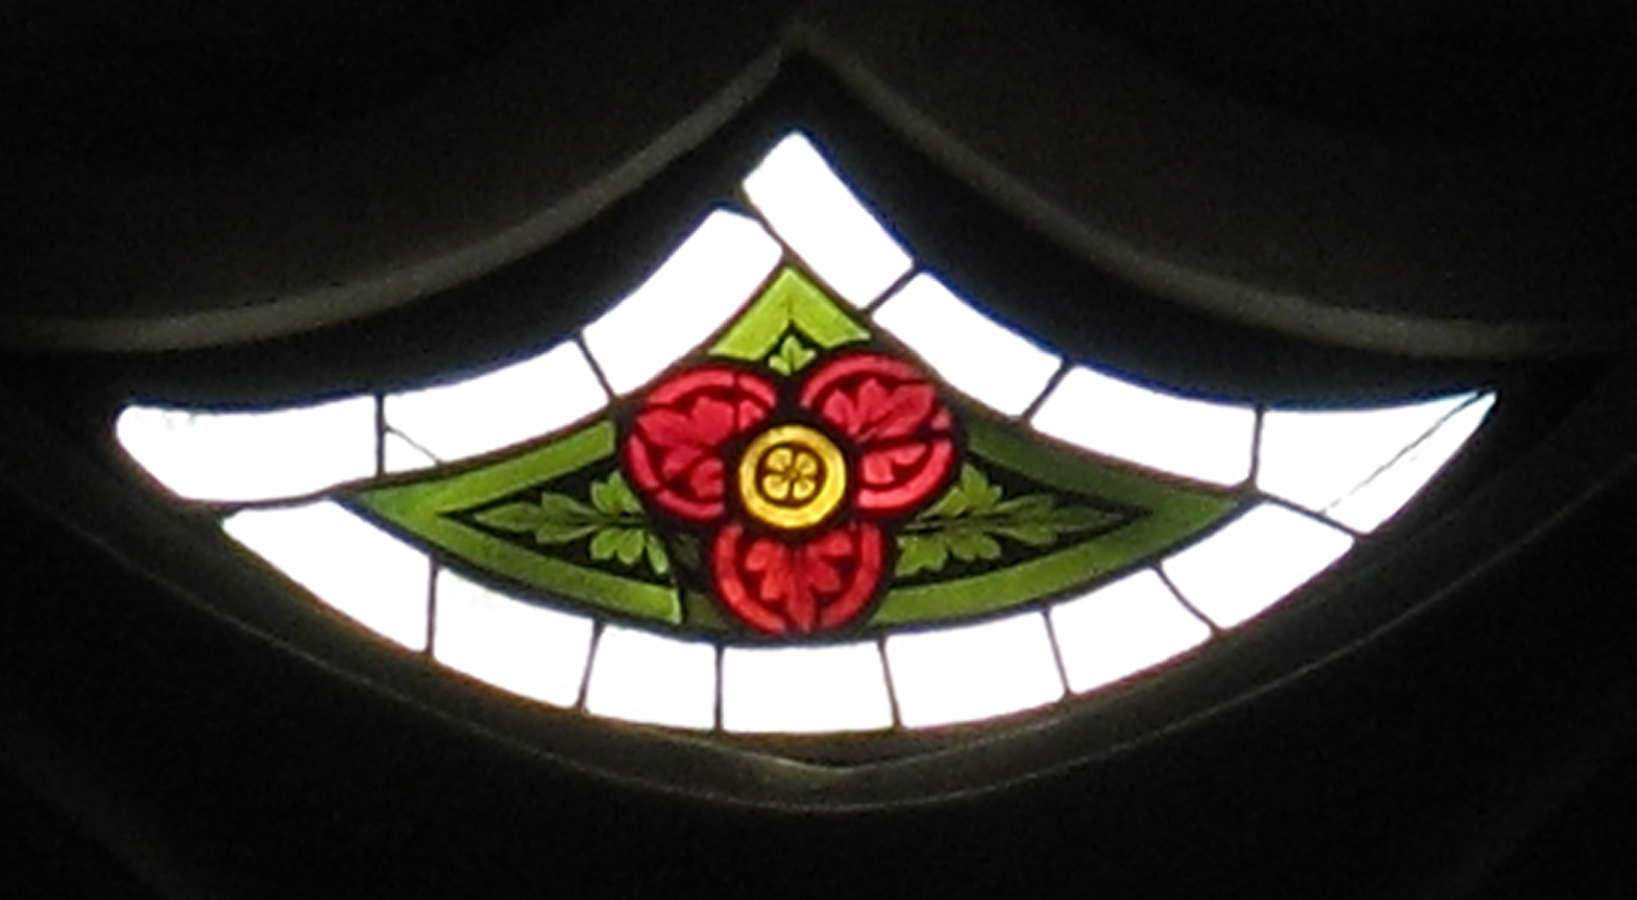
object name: tracery light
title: Triangular-shaped Tracery Light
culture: austrian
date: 1340-1350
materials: glass, metal, paint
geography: austria